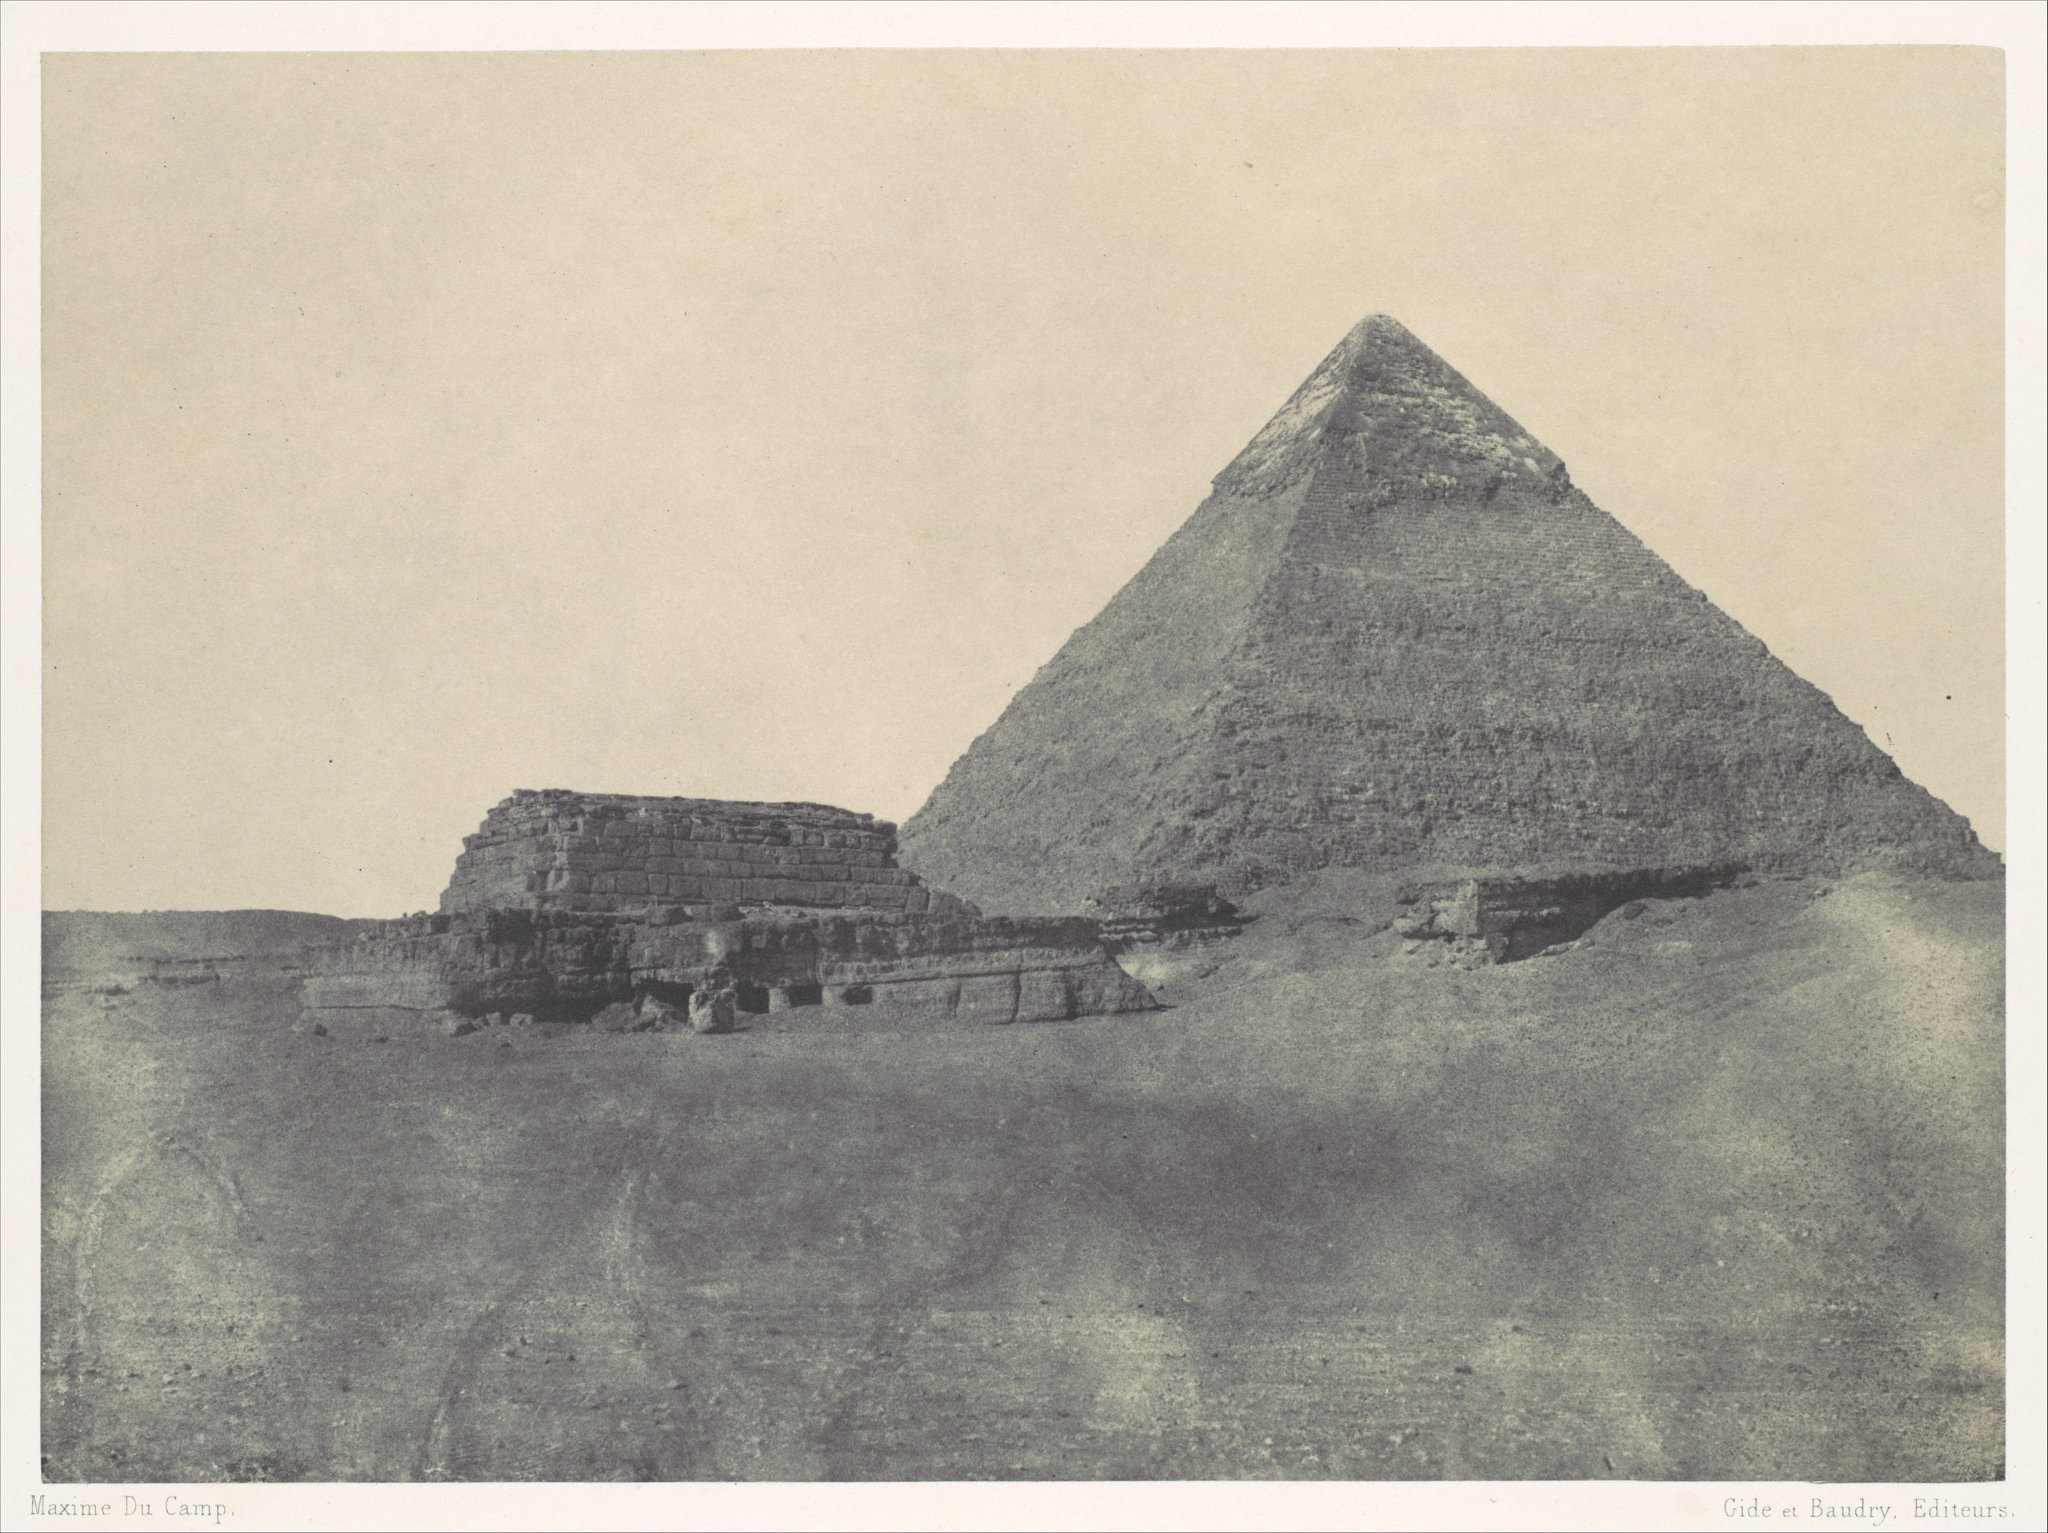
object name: photograph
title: Pyramid of Chephren (Khafre), Middle Egypt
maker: maxime du camp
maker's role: artist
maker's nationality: french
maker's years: 1822-1894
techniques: paper negative, salted paper print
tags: pyramids